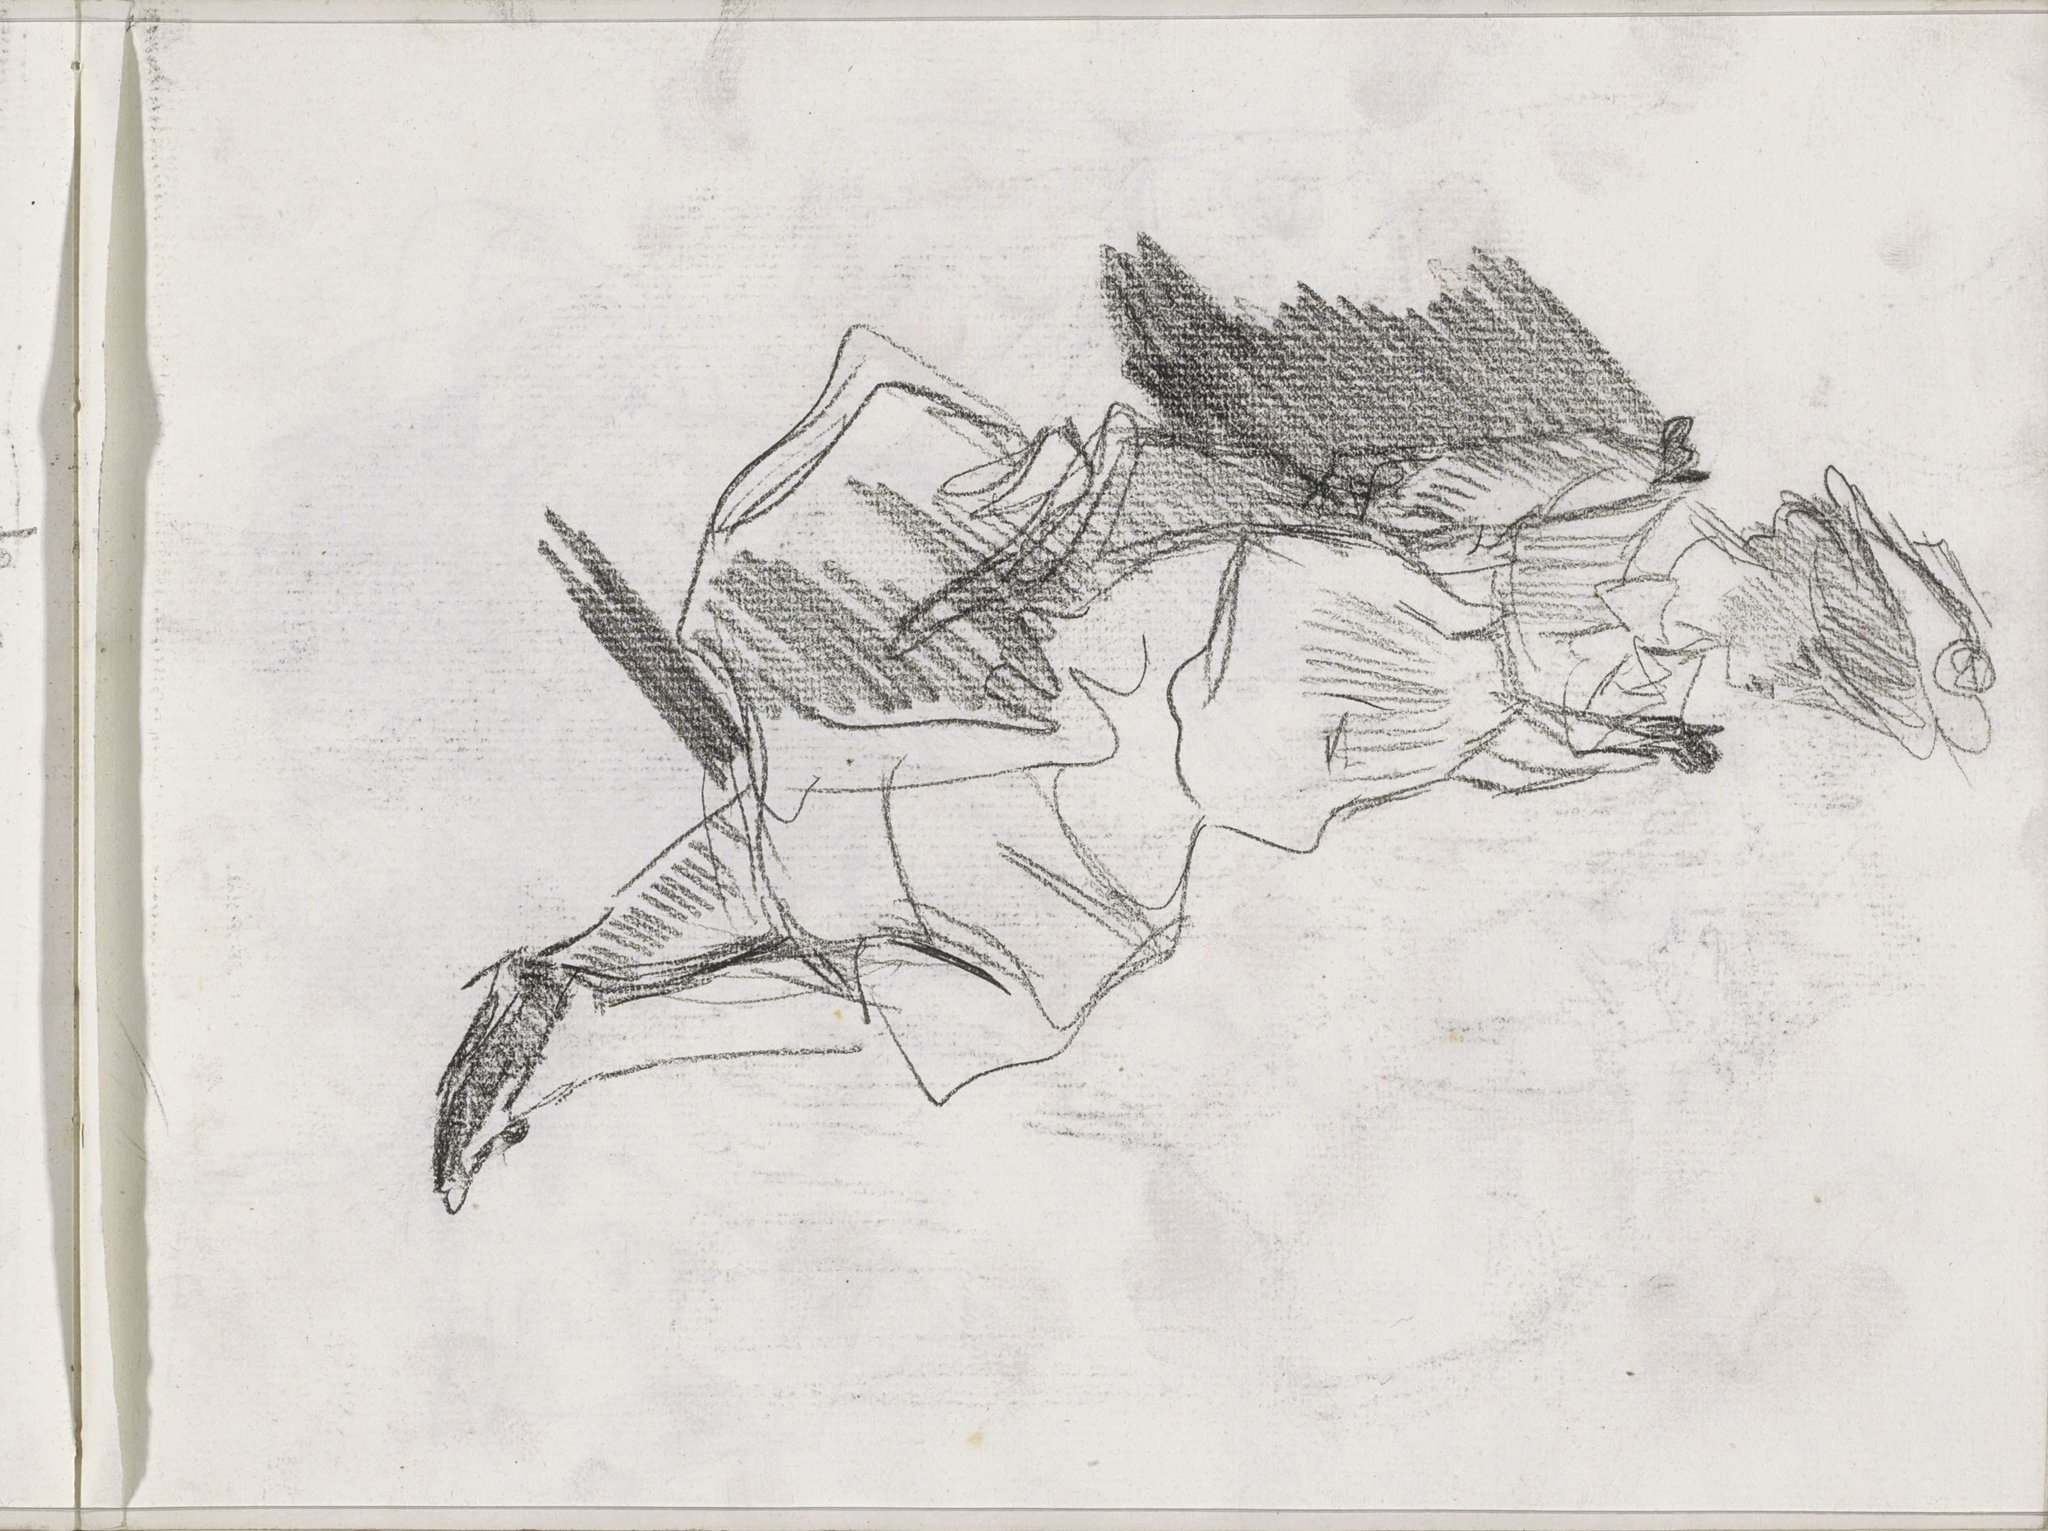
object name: sketchbook leaf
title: Zittende vrouw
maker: isaac israels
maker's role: draughtsman, painter, print maker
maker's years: 1865-1934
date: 1875-1934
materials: chalk, paper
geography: the hague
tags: adult woman (+ sitting)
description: Blad 20 recto uit schetsboek XXII met 30 bladen.